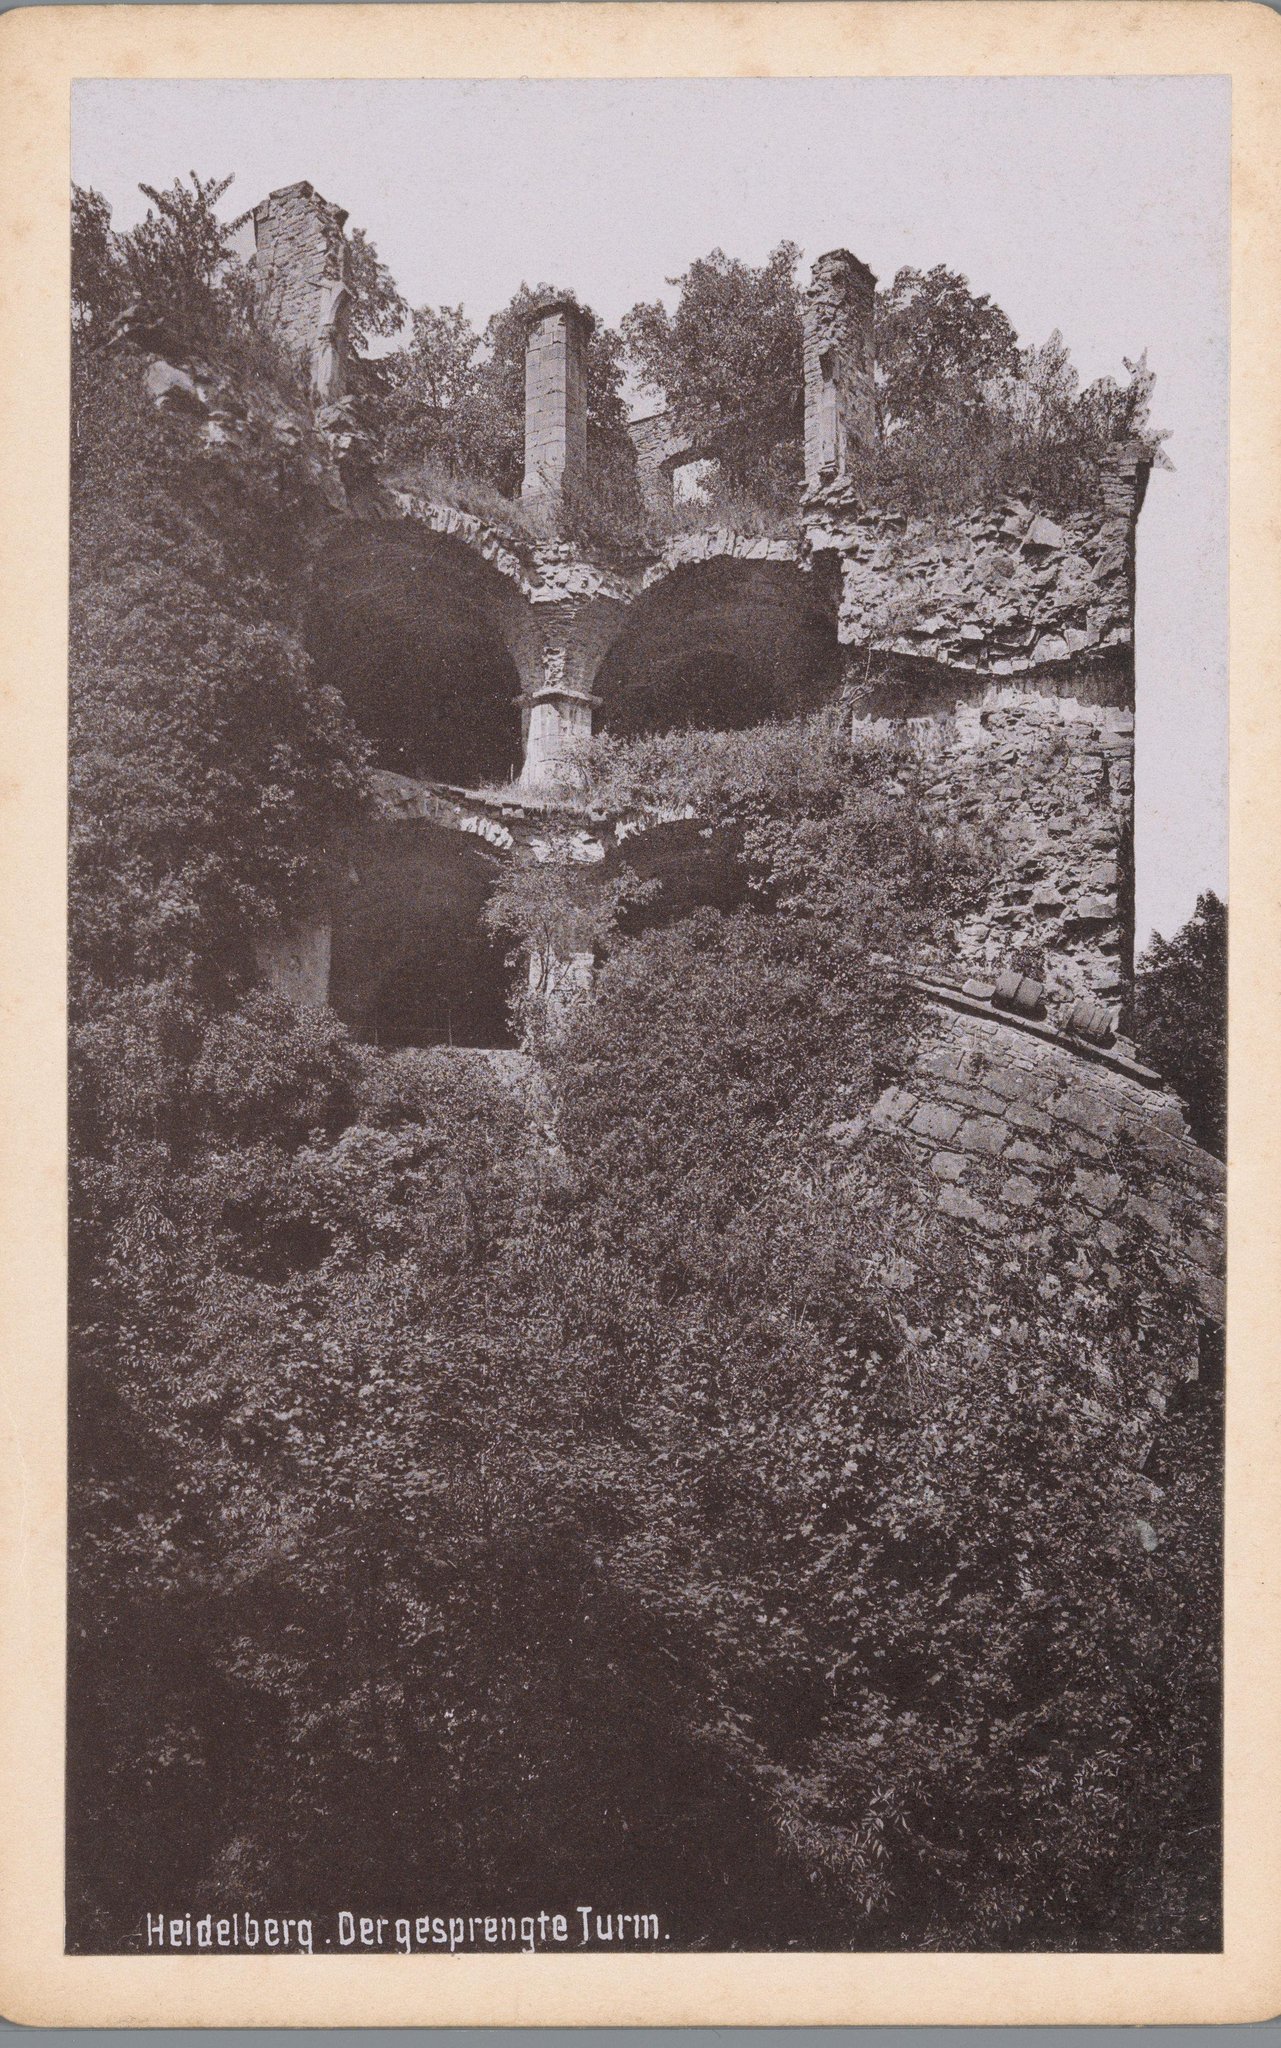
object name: cabinet photograph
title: Gezicht op de ruïne van de kruidtoren bij Schloss Heidelberg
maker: Anonymous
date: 1870-1900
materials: cardboard, paper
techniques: photograph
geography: heidelberg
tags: ruin of a building ~ architecture, landscape with ruins, tower (of house or building)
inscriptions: inscription: ‘Heidelberg (slot/, 3 Aug. 1900.’